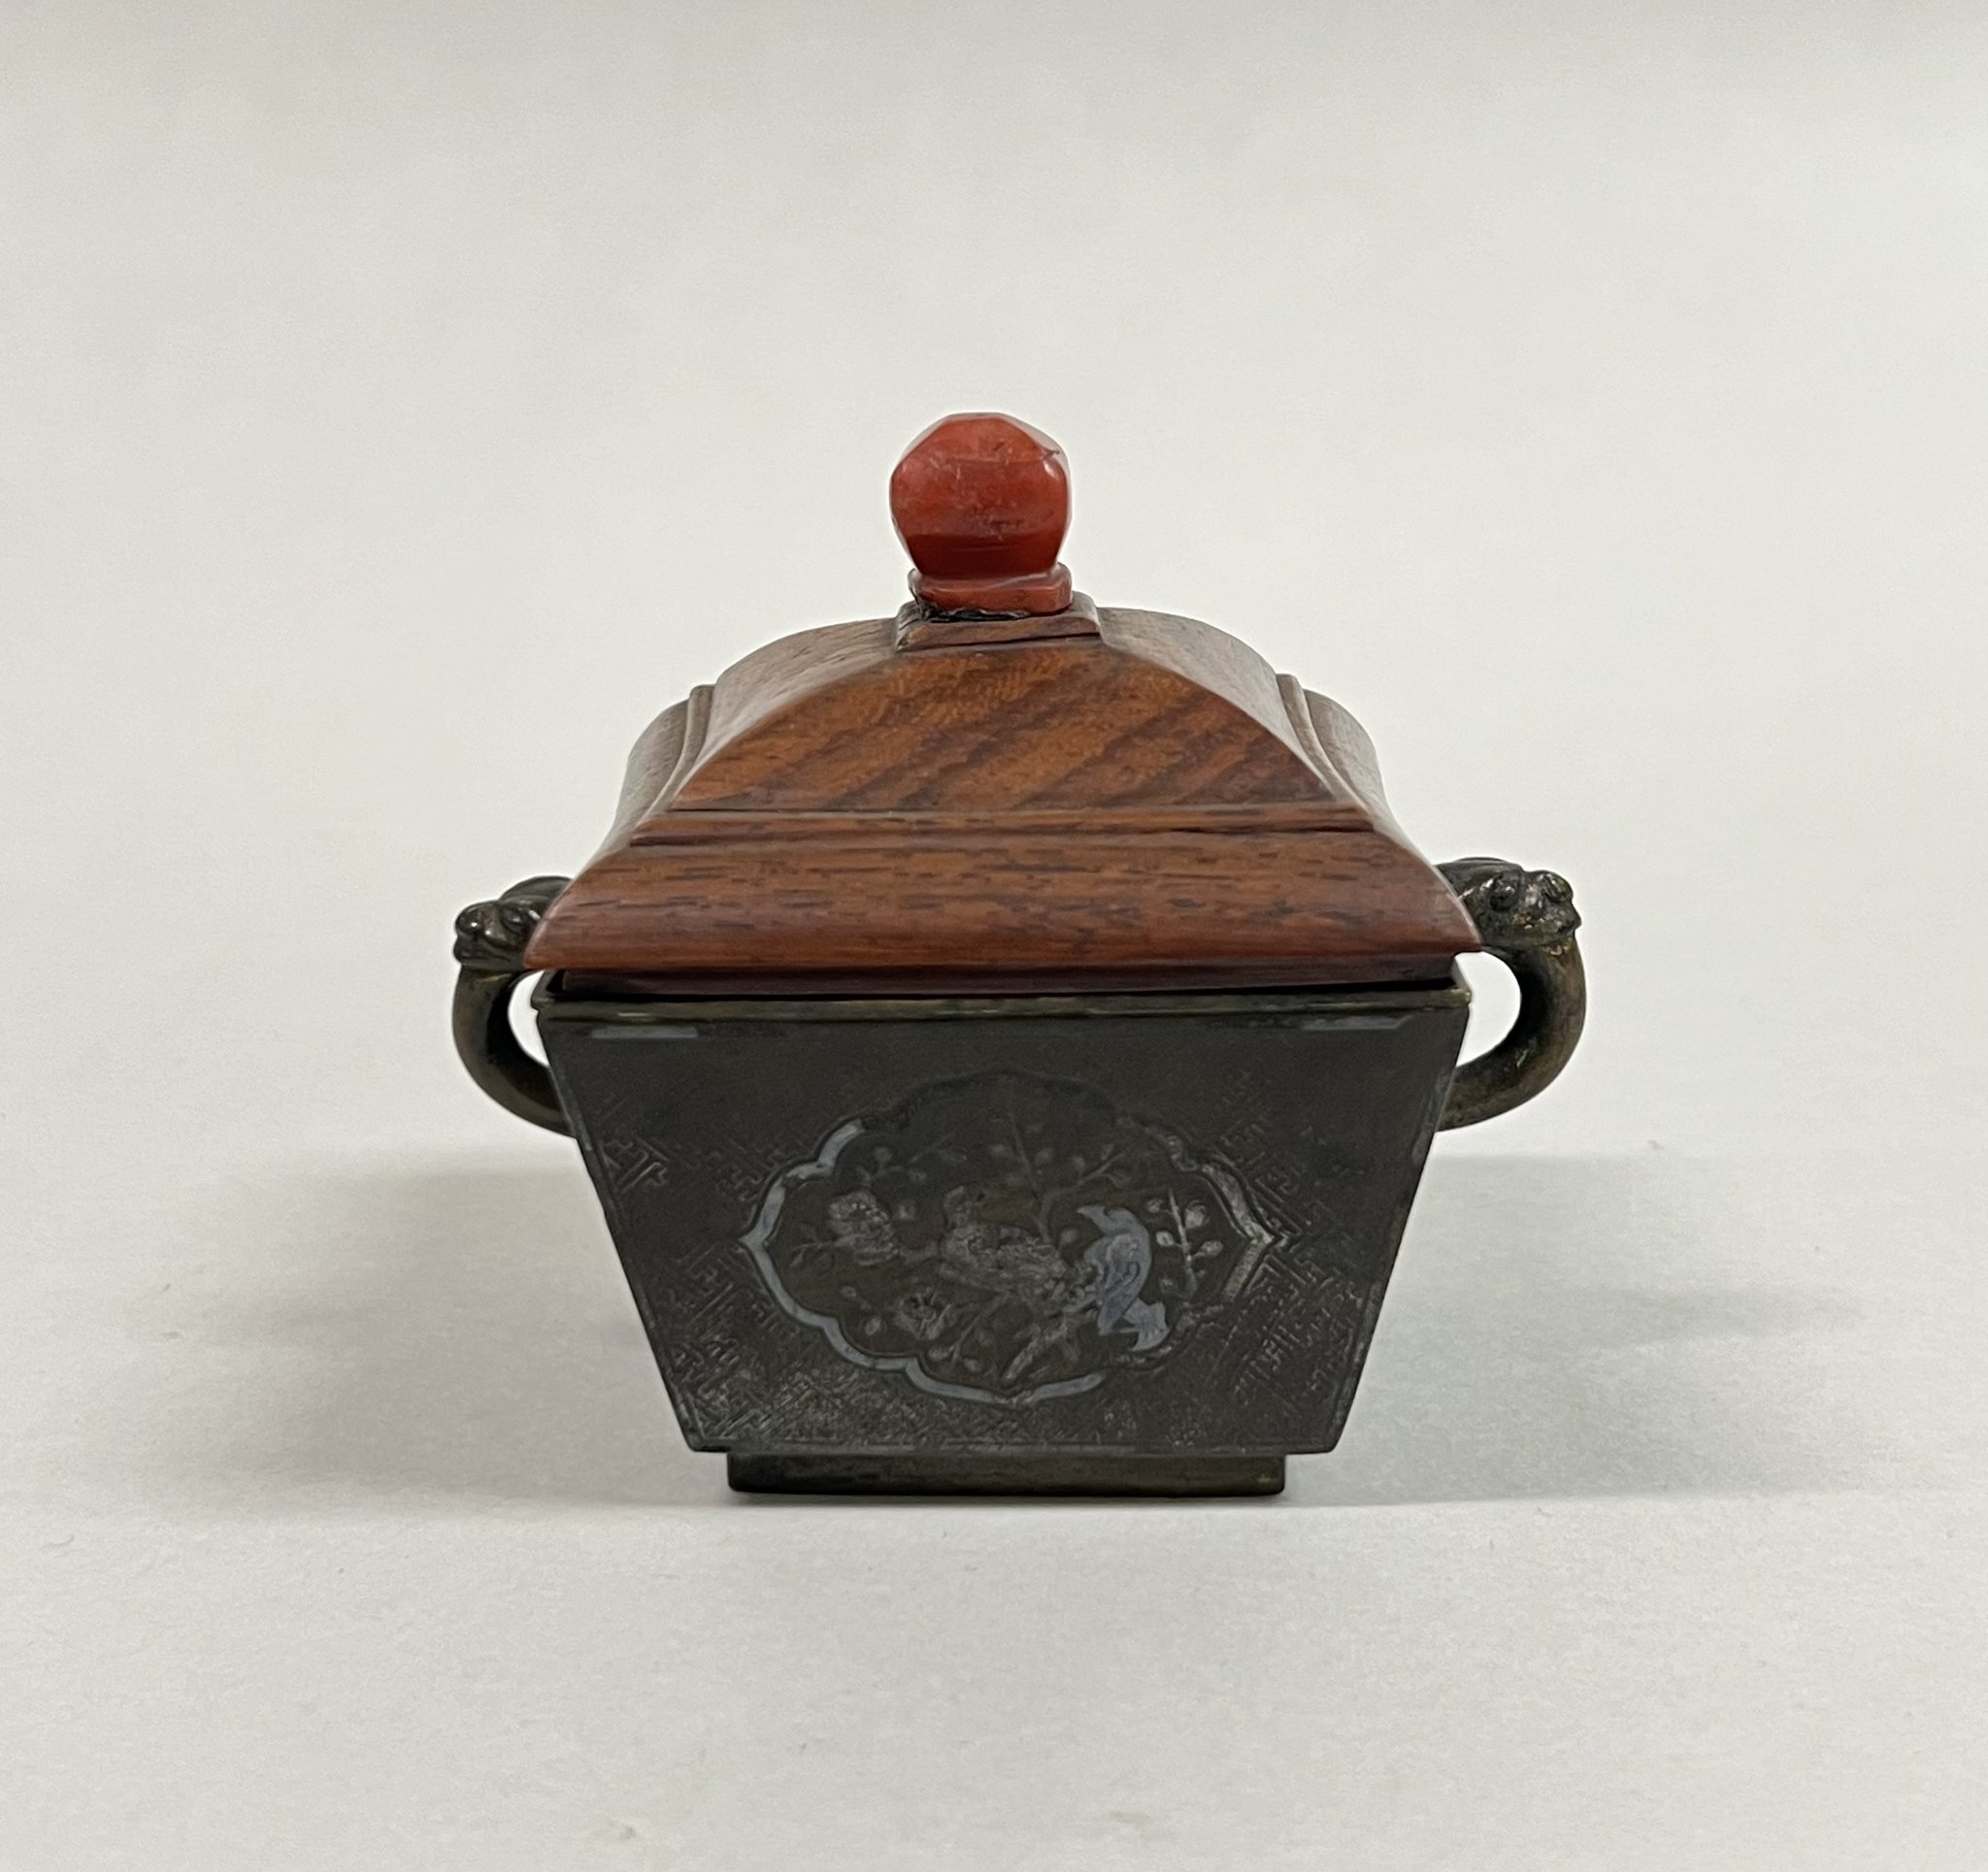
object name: cup with cover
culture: chinese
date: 1701-1800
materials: bronze, silver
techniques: inlay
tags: flowers